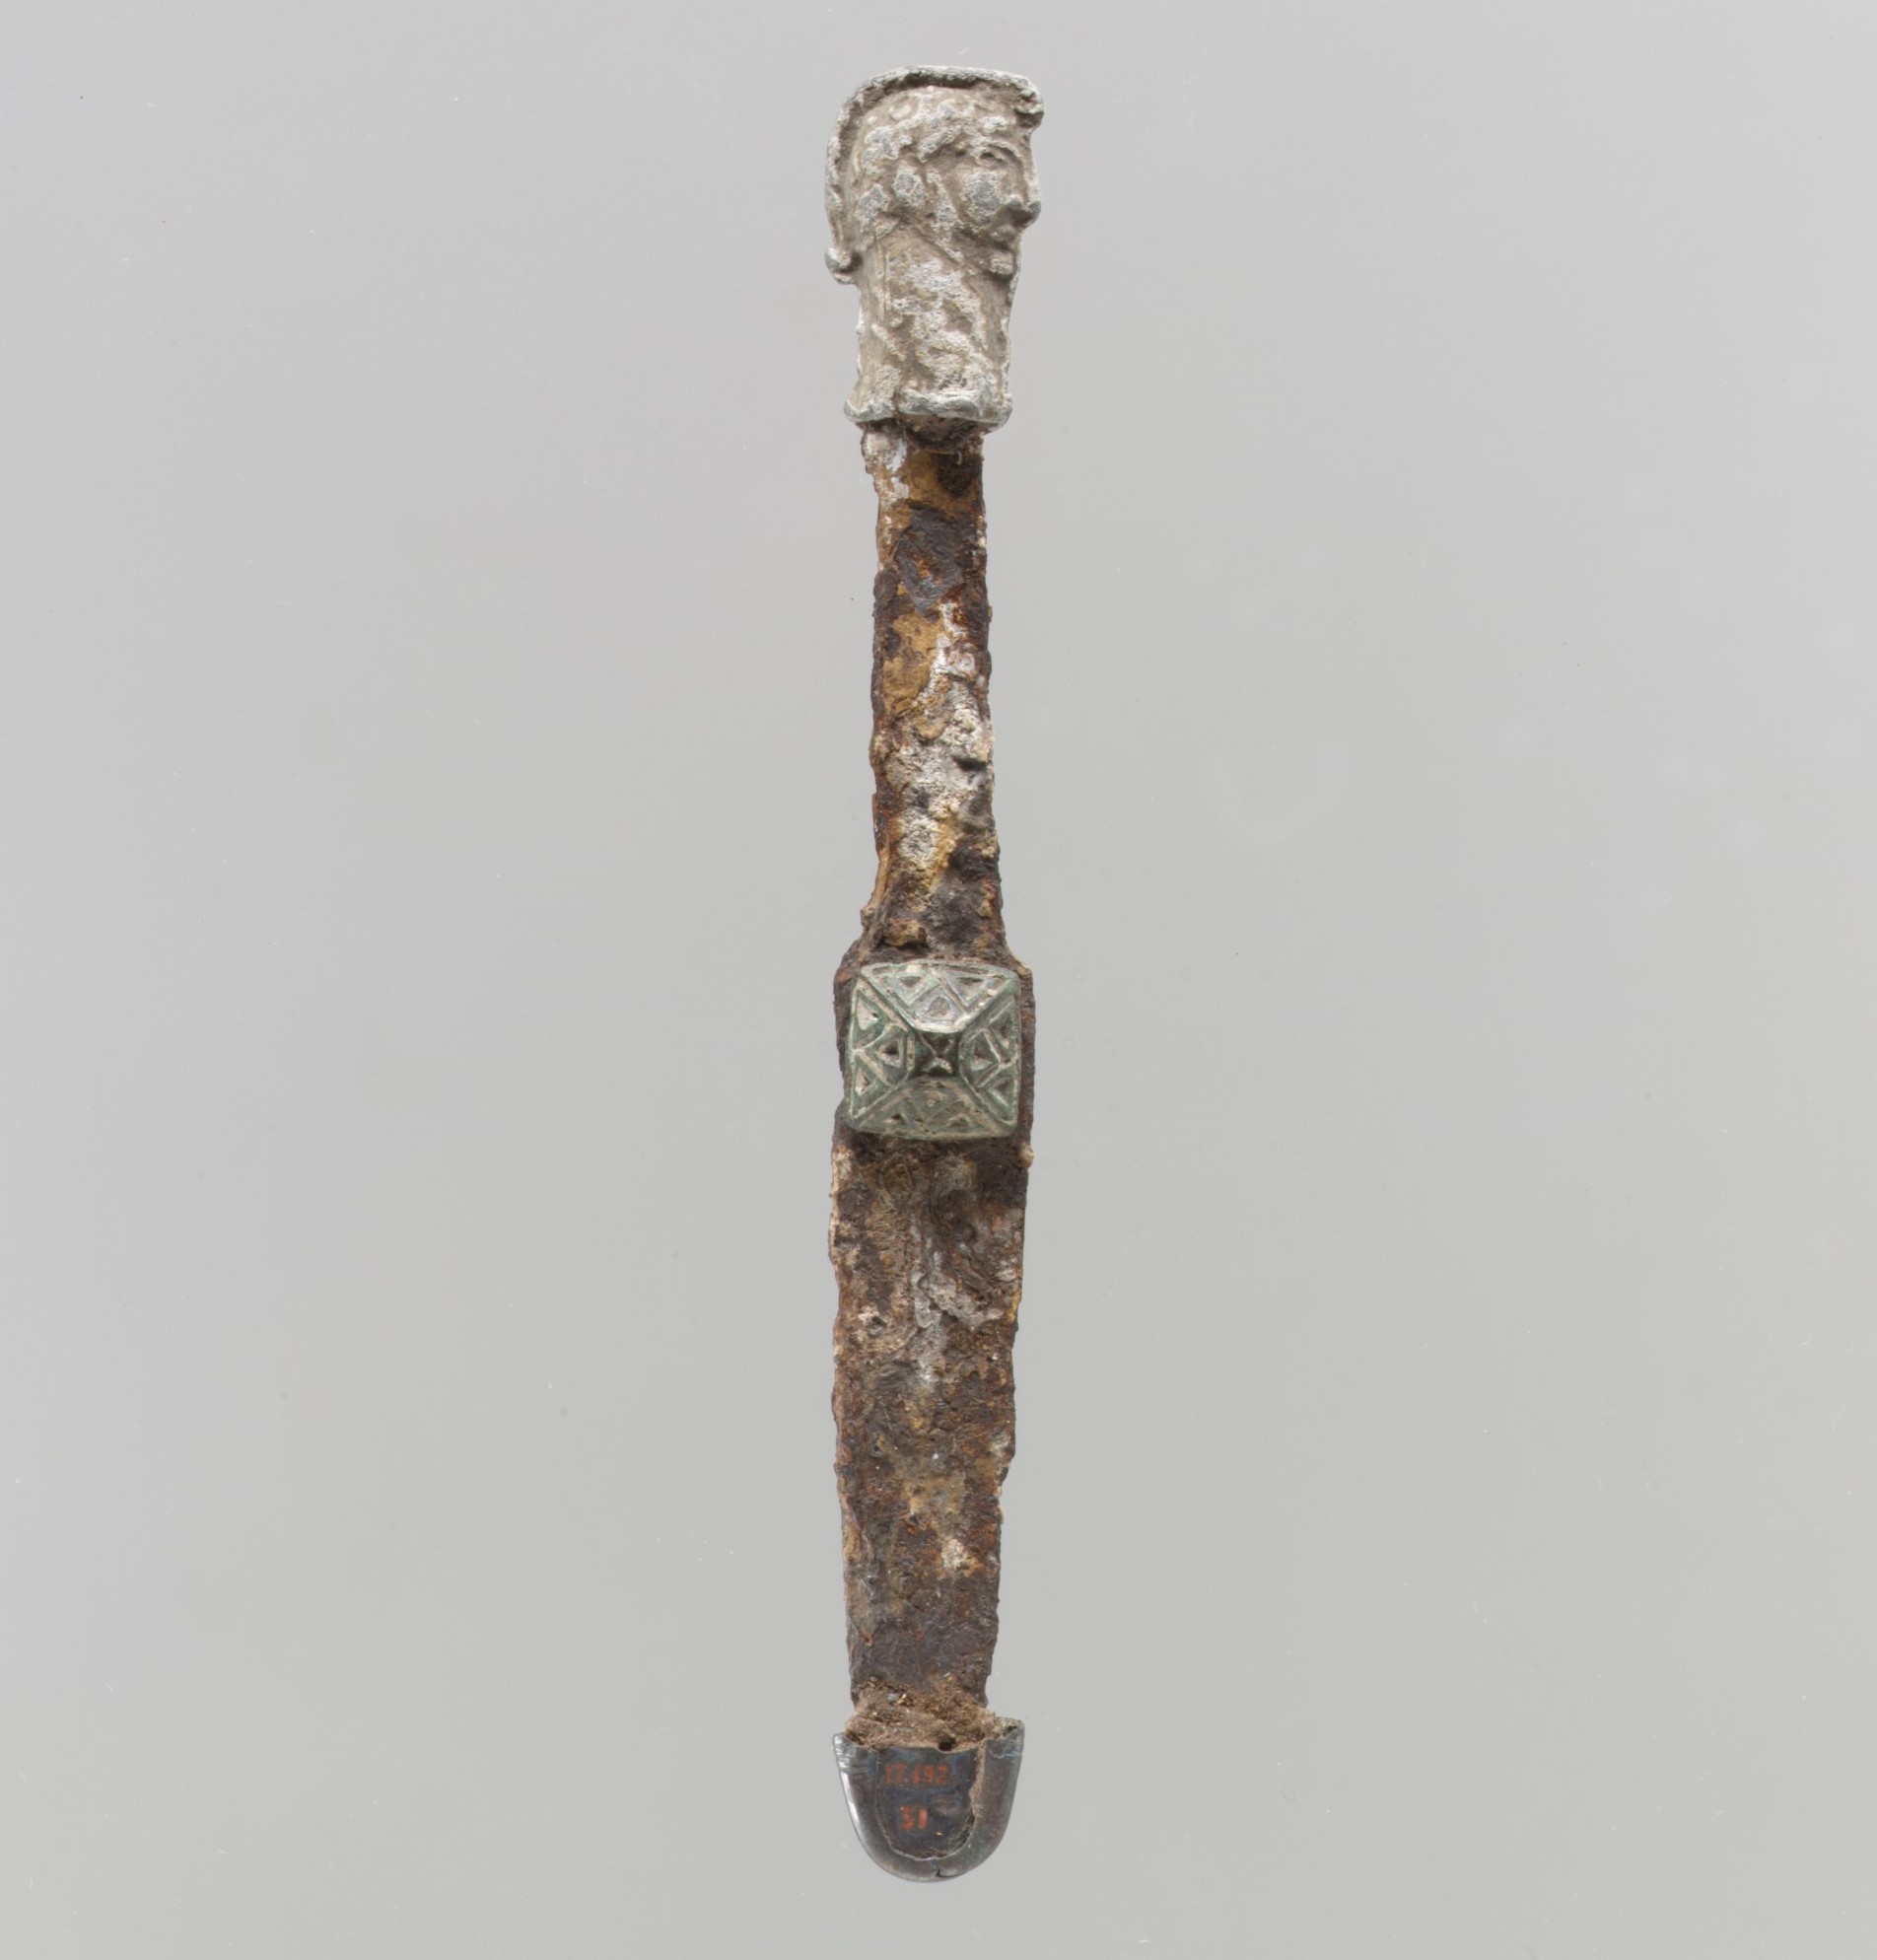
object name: dagger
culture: roman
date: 201-300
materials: copper alloy, iron, silver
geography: gaul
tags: heads,men